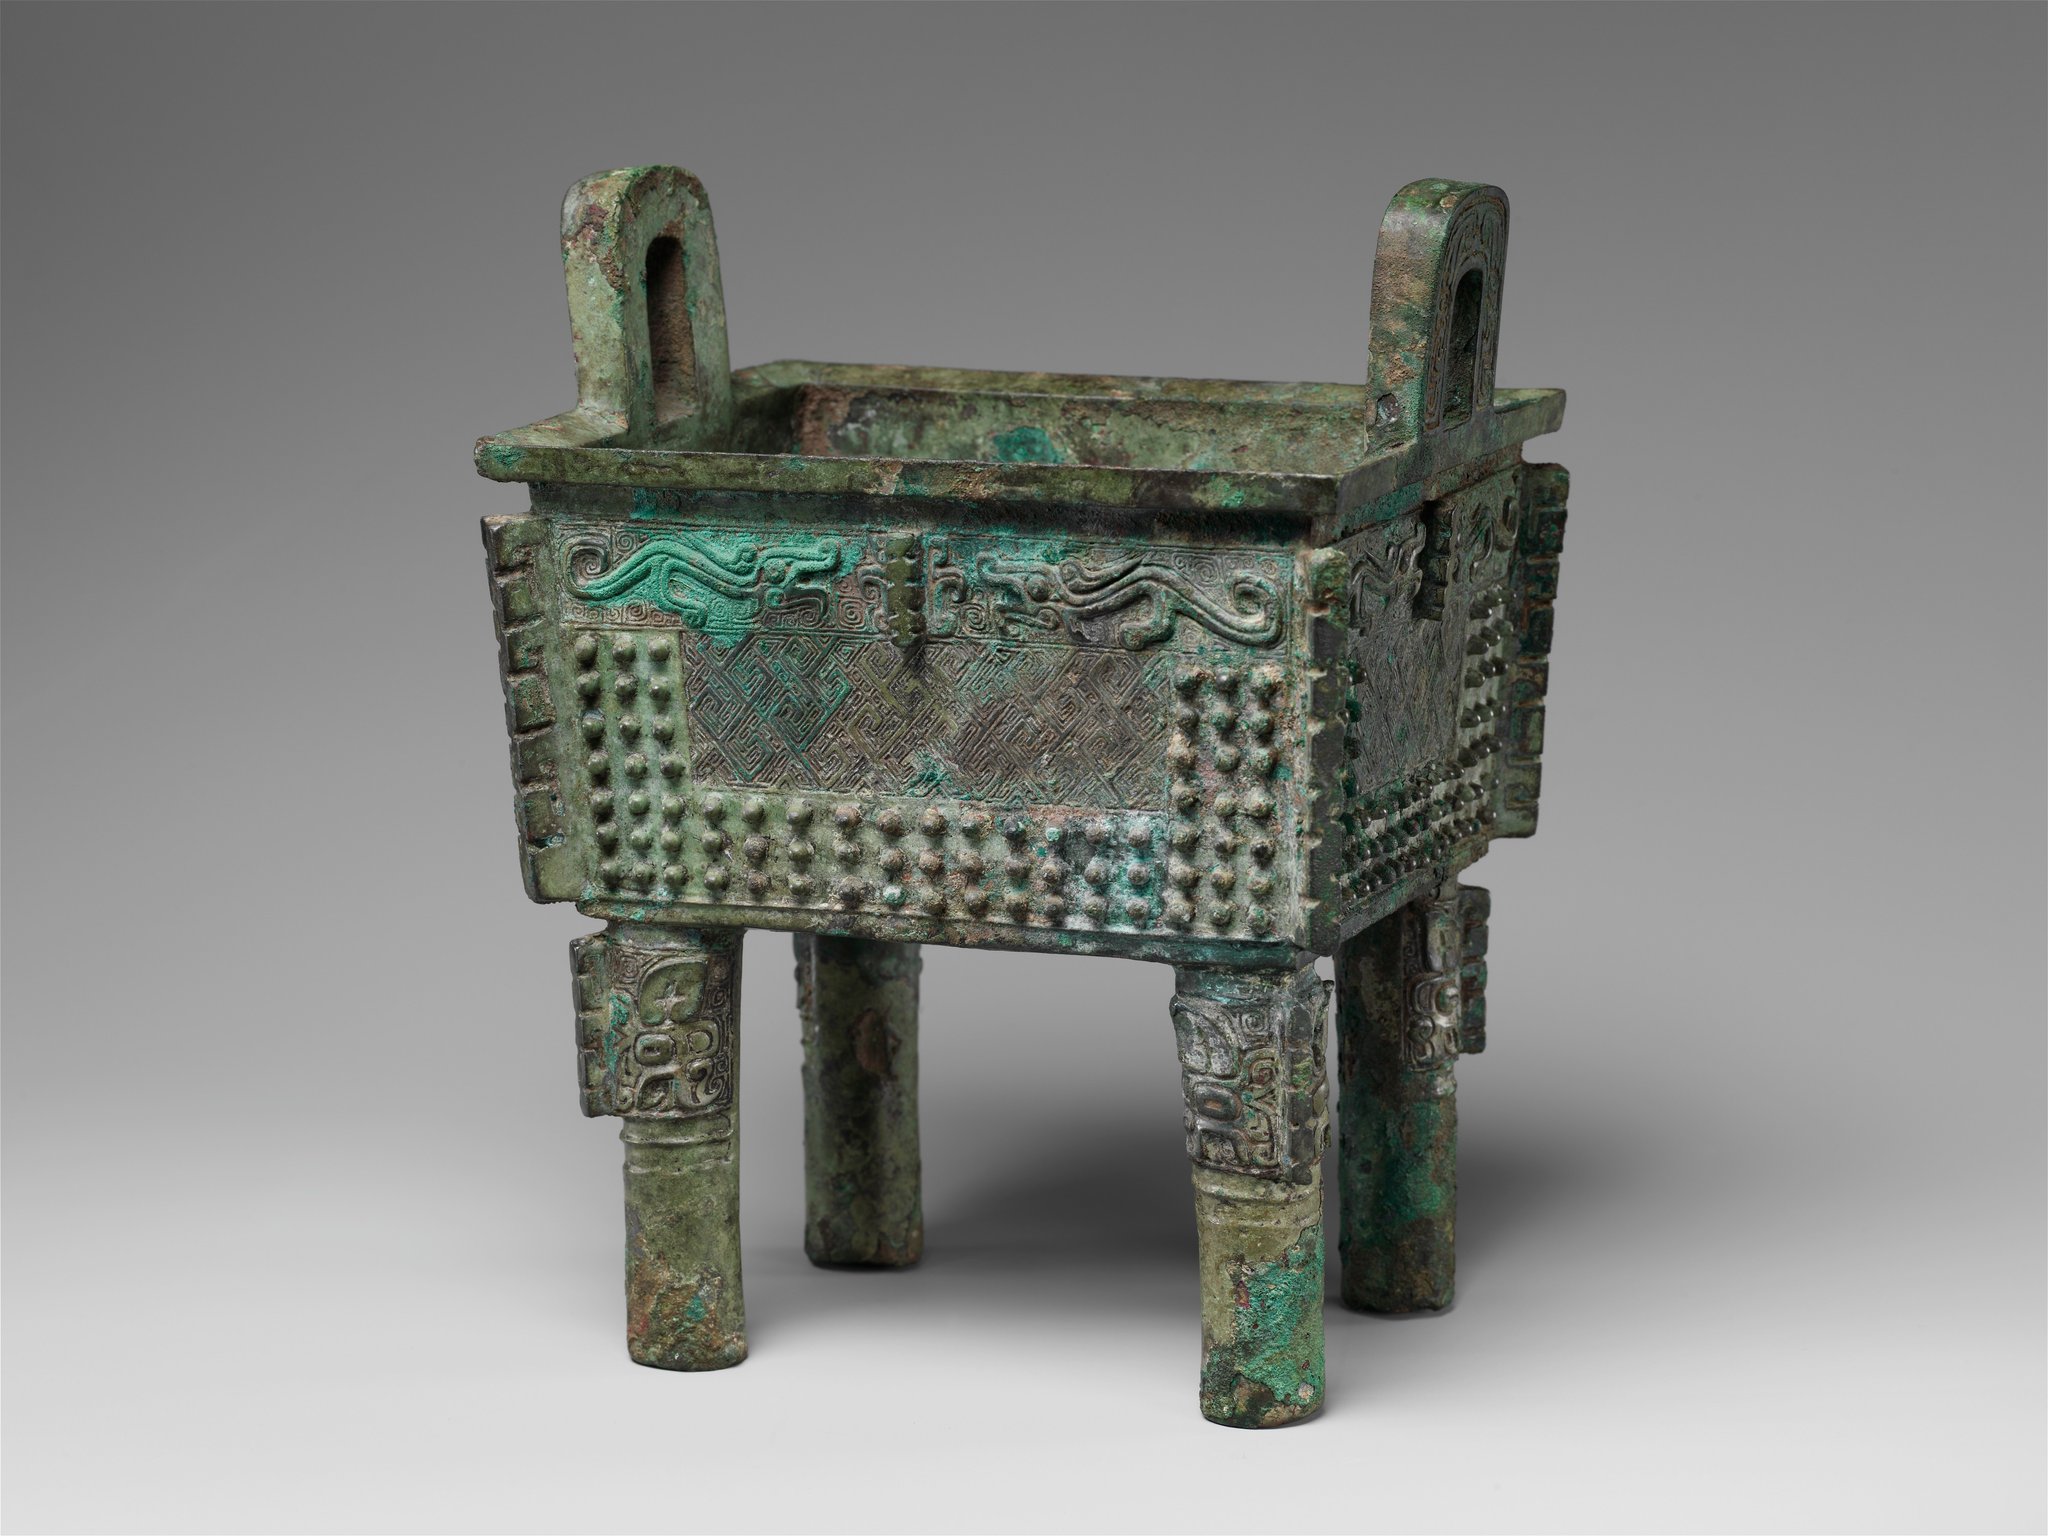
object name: cauldron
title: Rectangular cauldron (Fangding)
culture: chinese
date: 1300-1001 BCE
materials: bronze